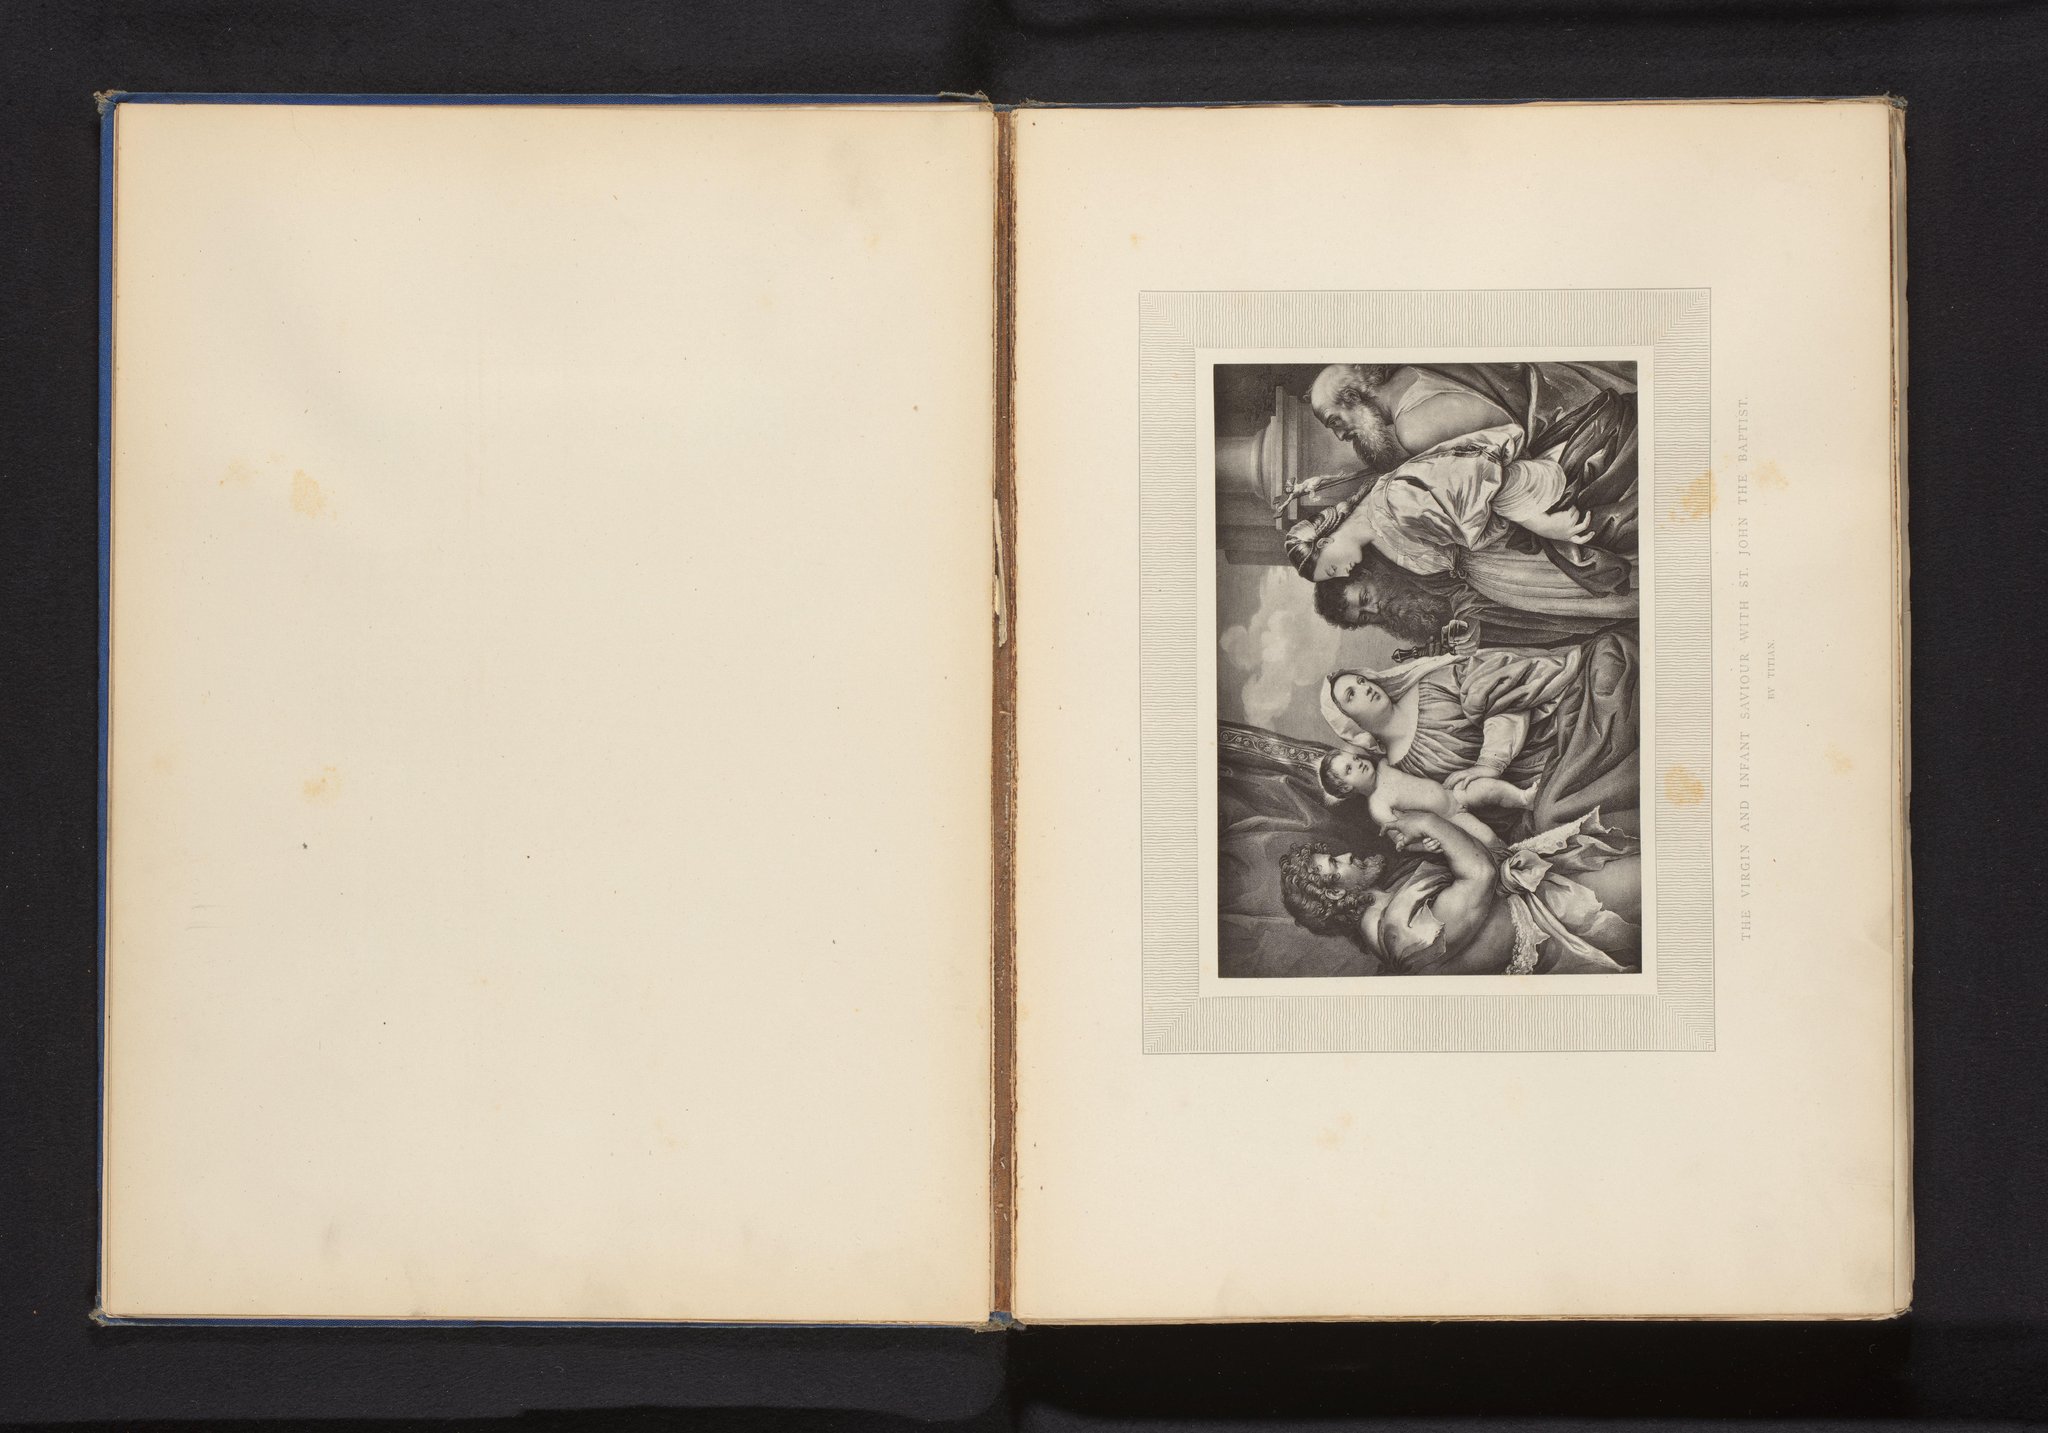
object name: page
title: The virgin and infant saviour with St. John the Baptist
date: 1870-1875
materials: paper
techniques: woodburytype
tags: madonna: i.e. mary with the christ-child, series of scenes from the life of john the baptist